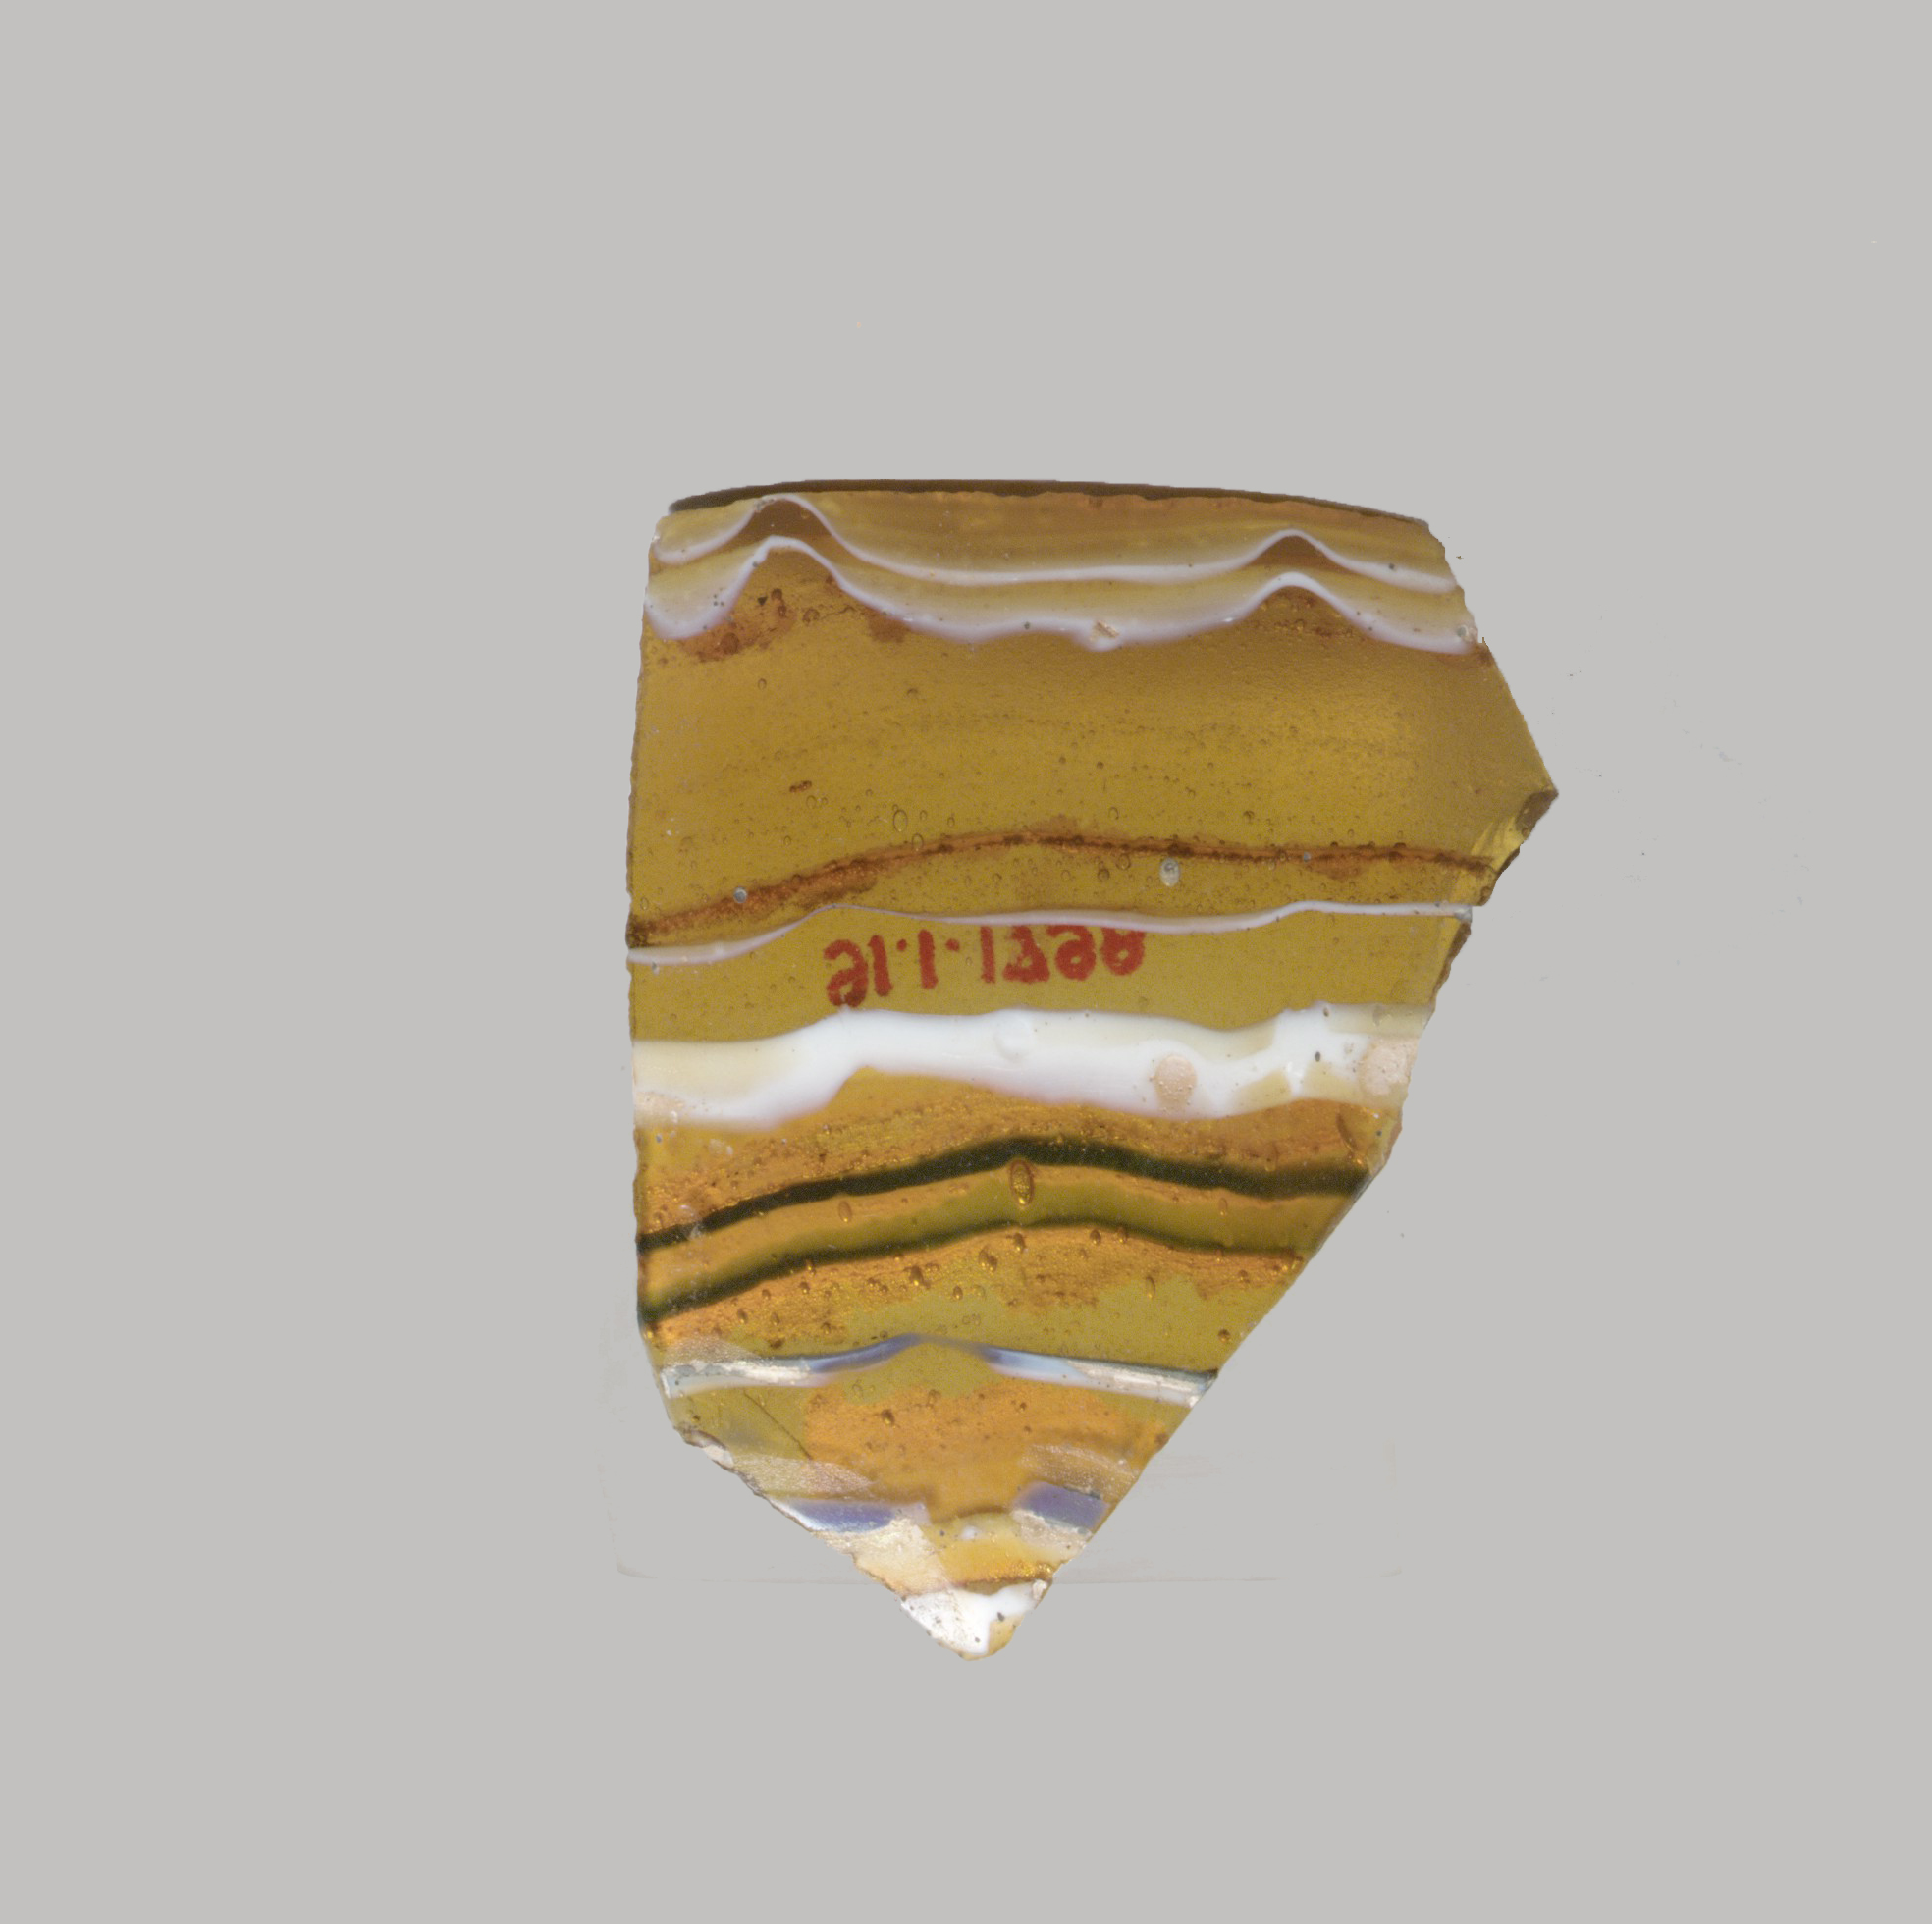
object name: fragment, mosaic bowl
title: Glass mosaic bowl fragment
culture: roman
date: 34 BCE-33 CE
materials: glass